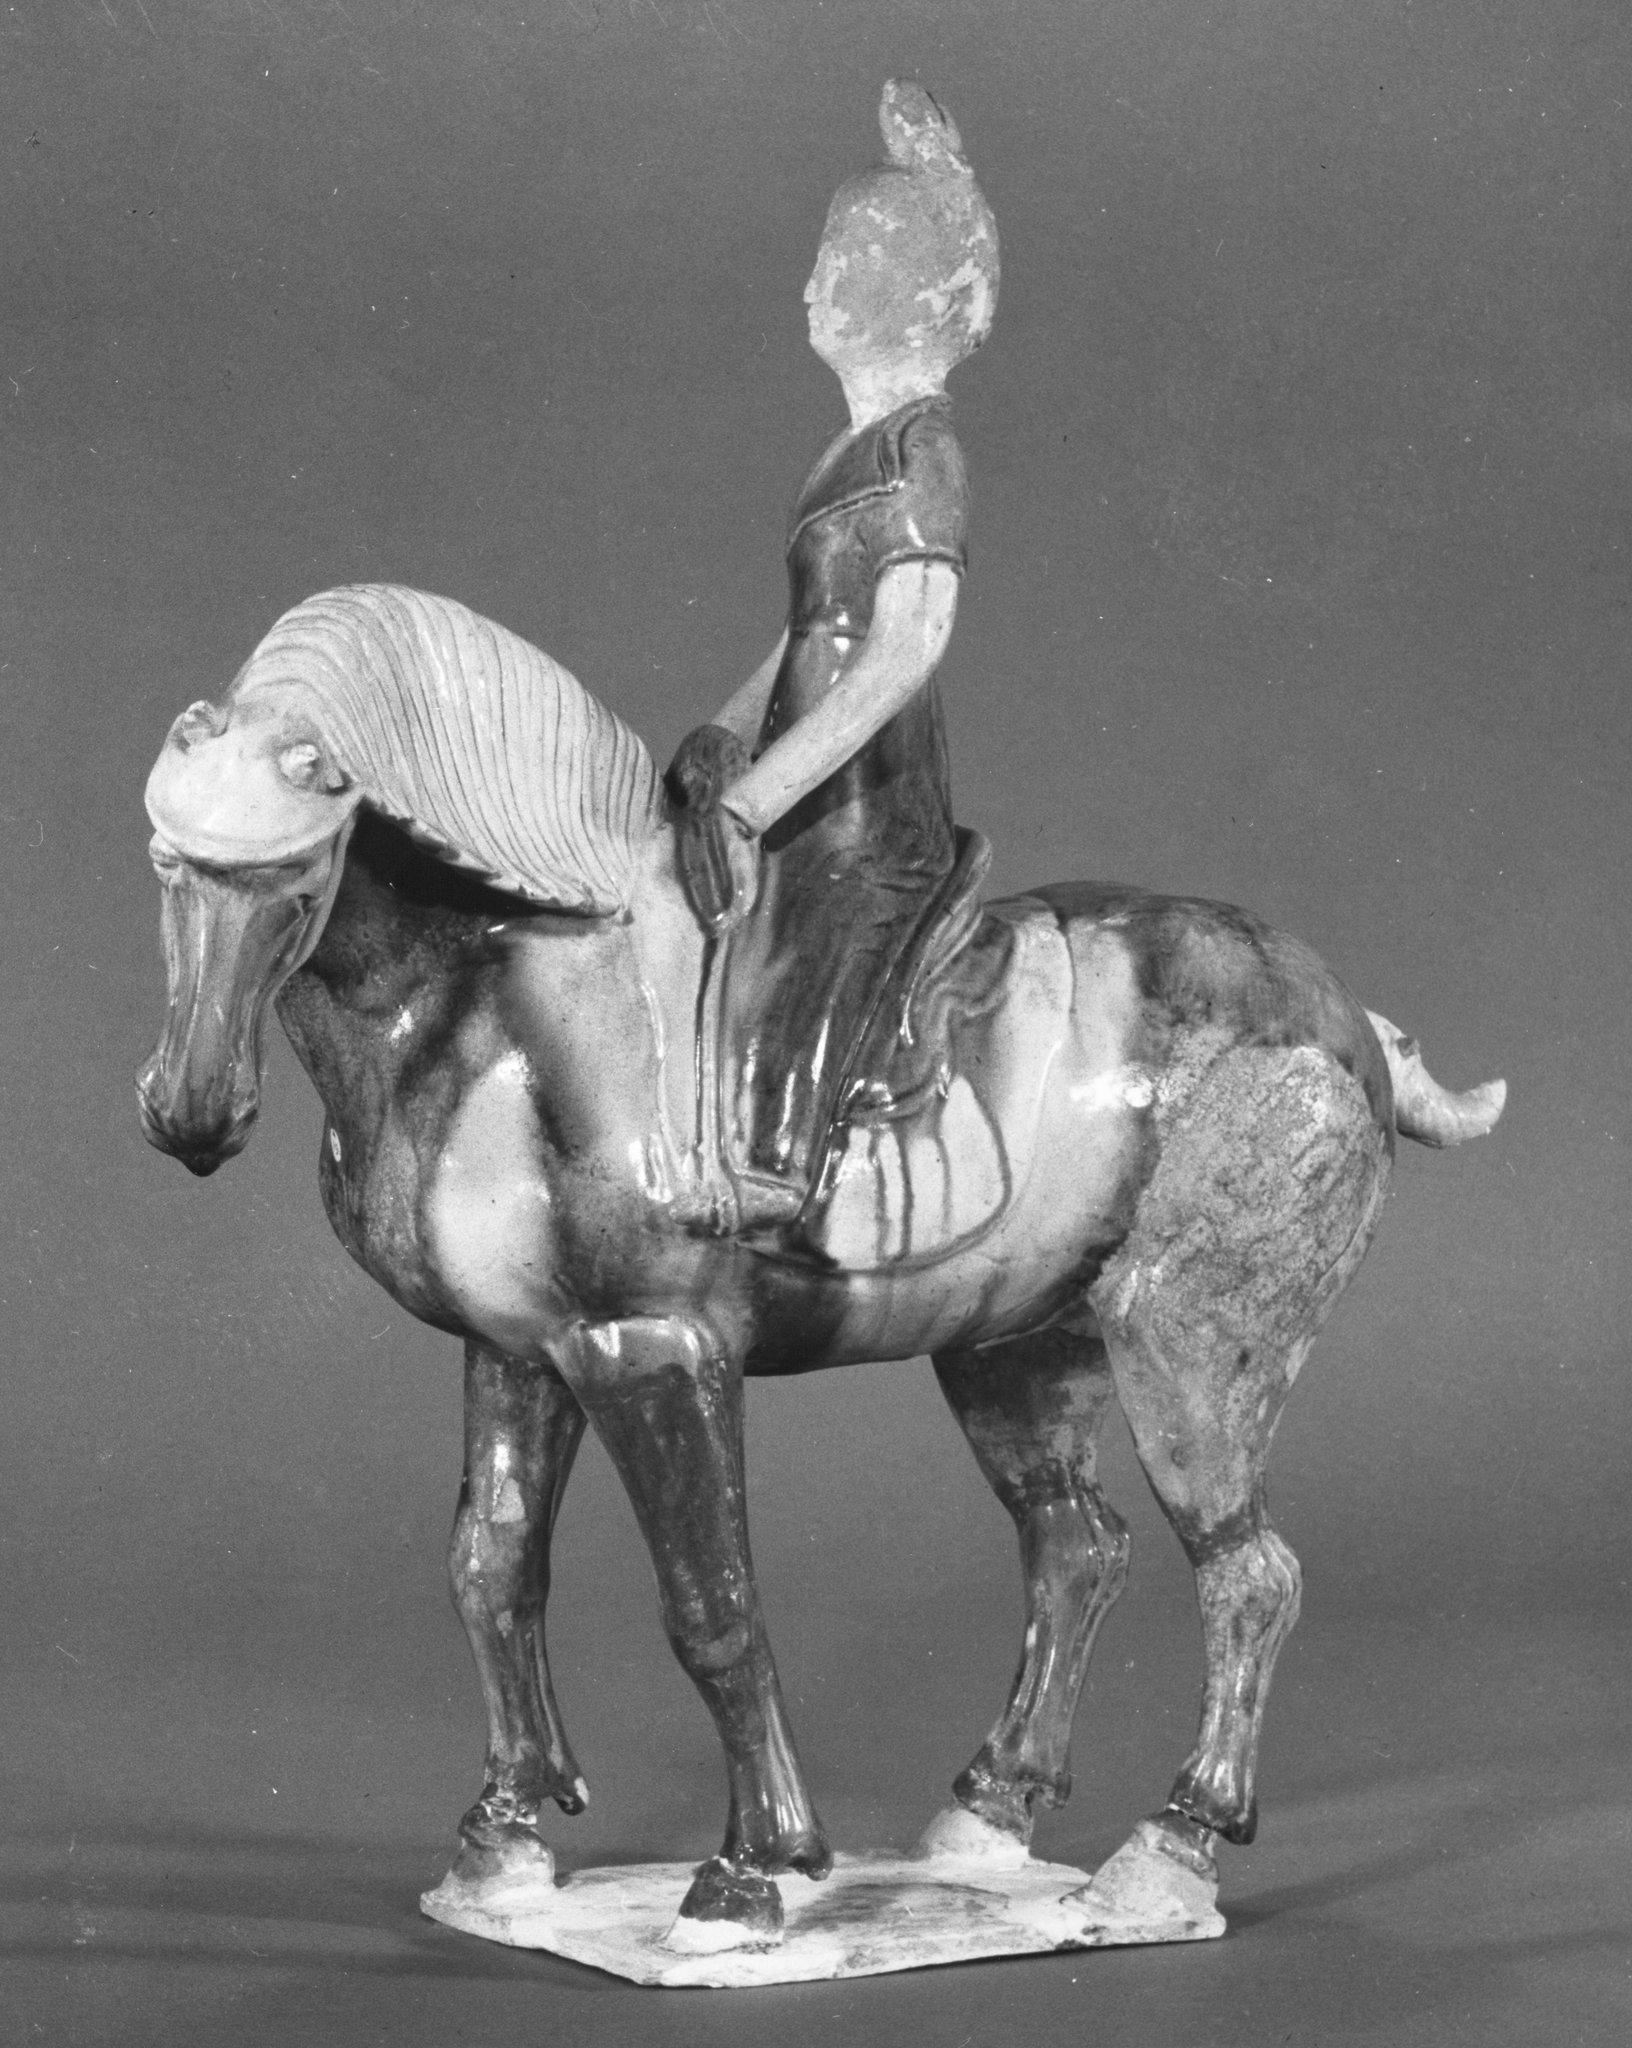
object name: figure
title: Horse and female rider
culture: chinese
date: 601-800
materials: earthenware, glaze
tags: horses